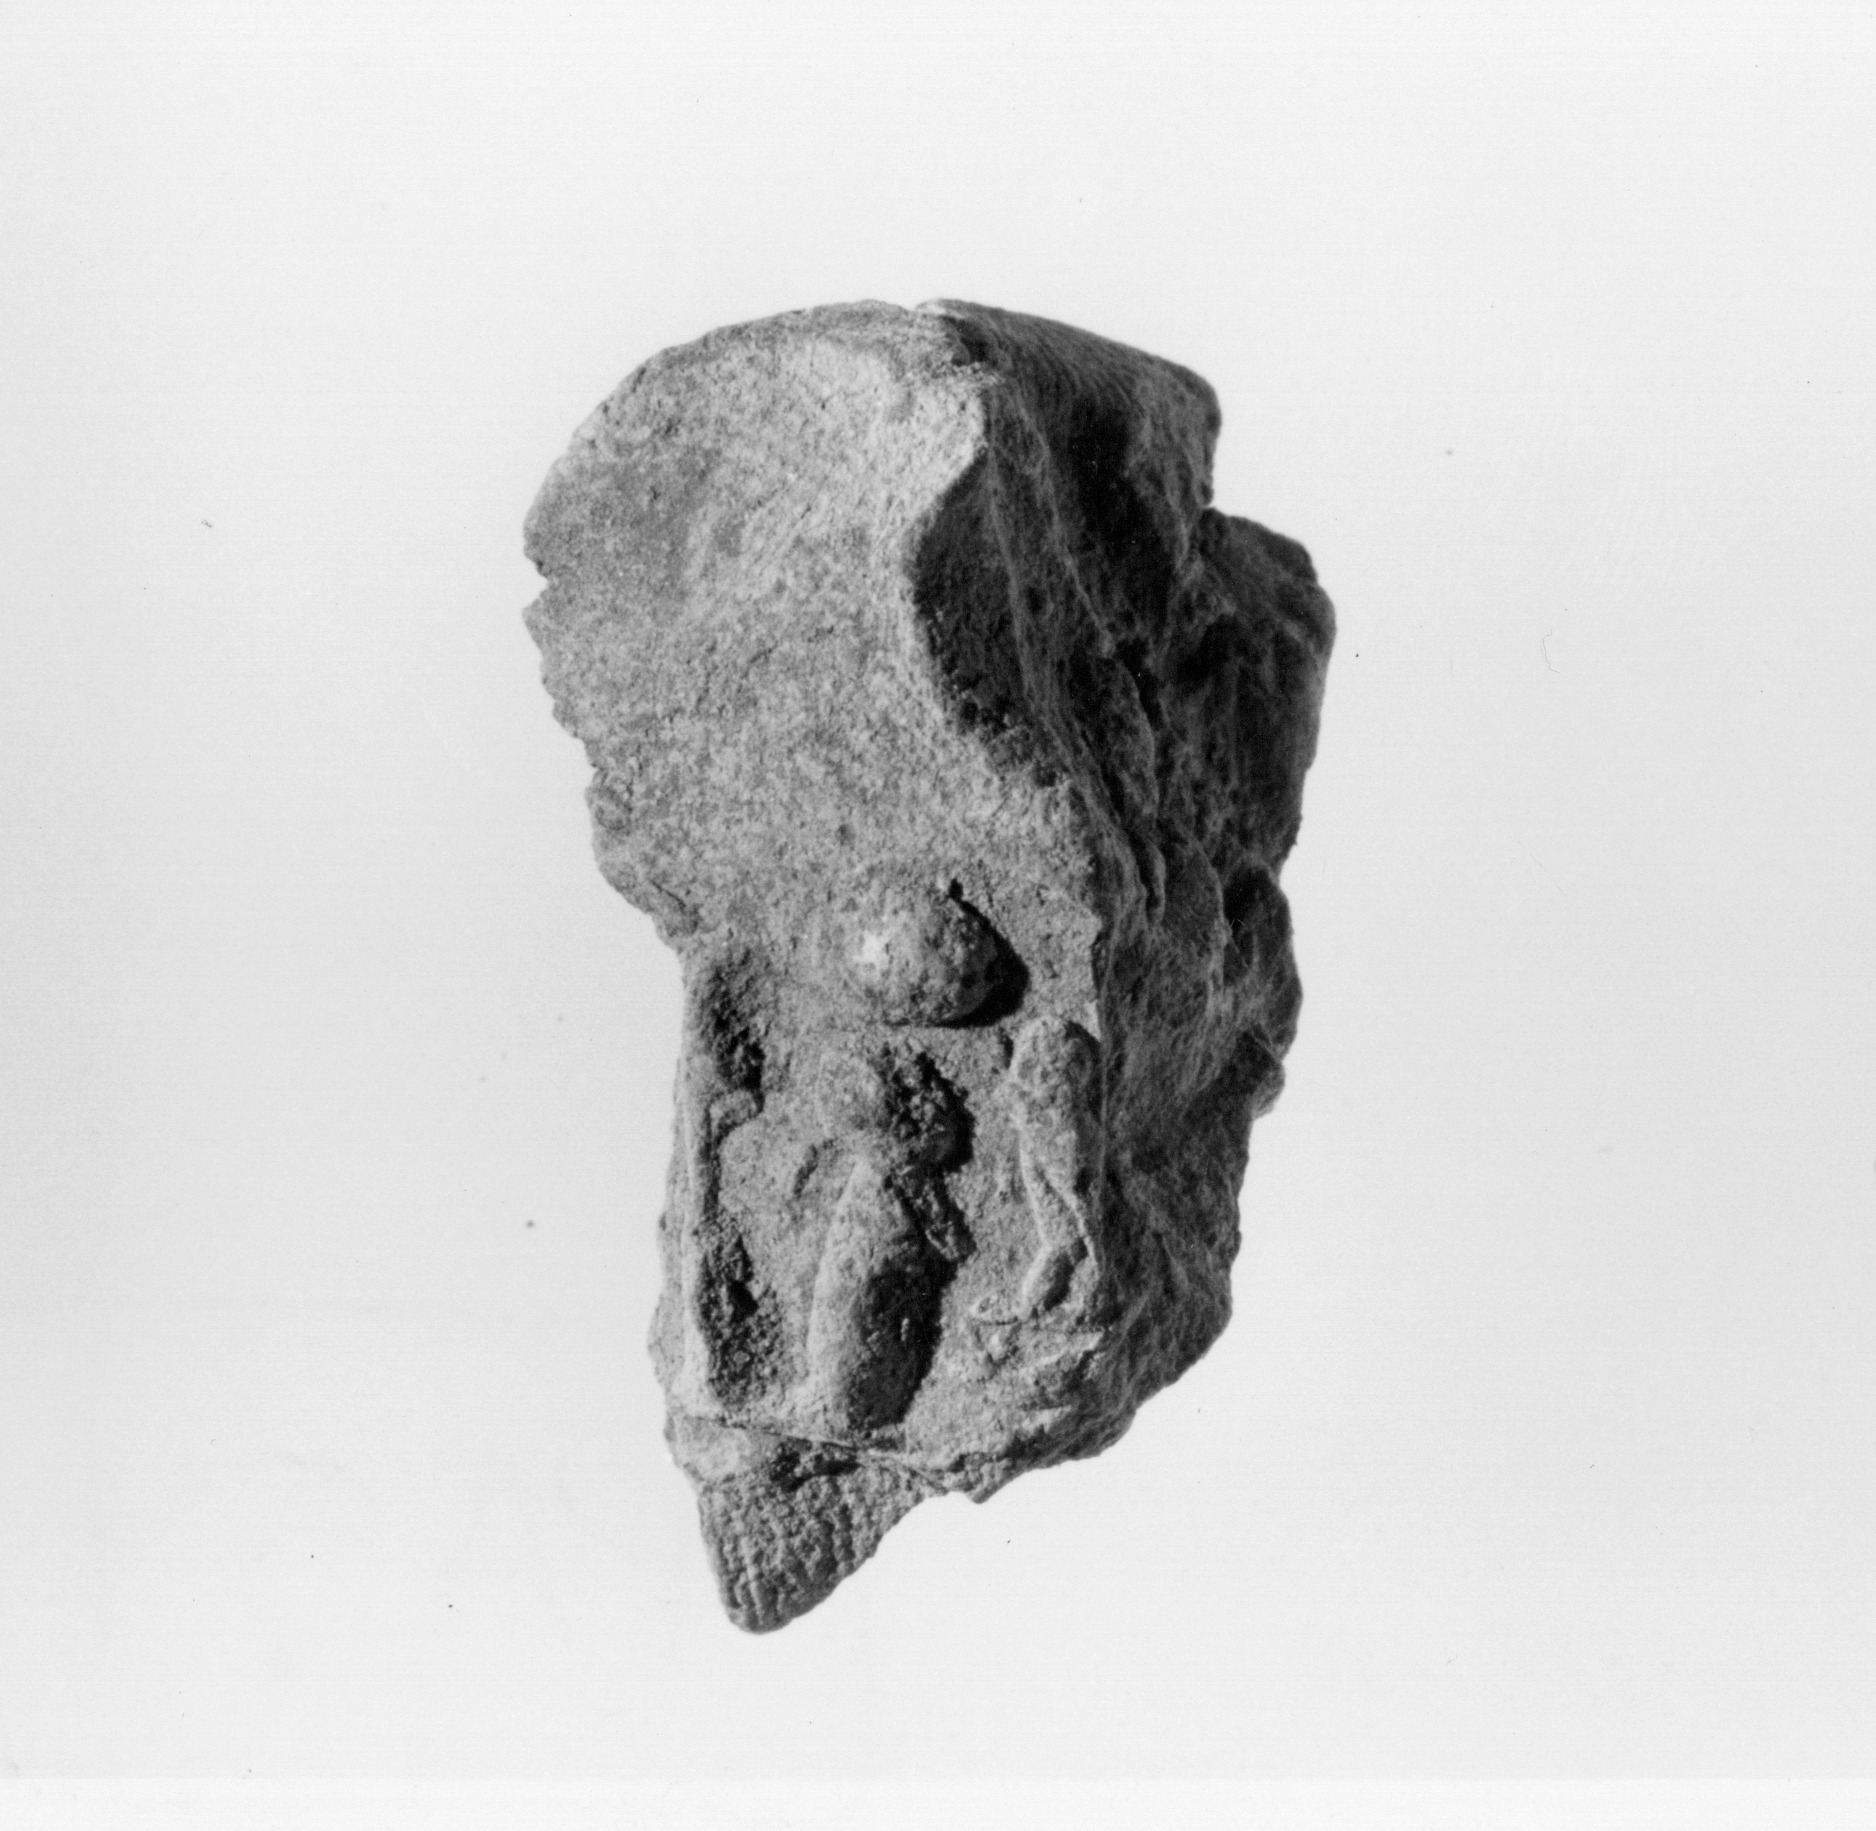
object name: sealing, nebmaatre, amenhotep iii, lower egypt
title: Document Sealing With the Throne Name of Amenhotep III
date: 1390-1352 BCE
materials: mud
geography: egypt